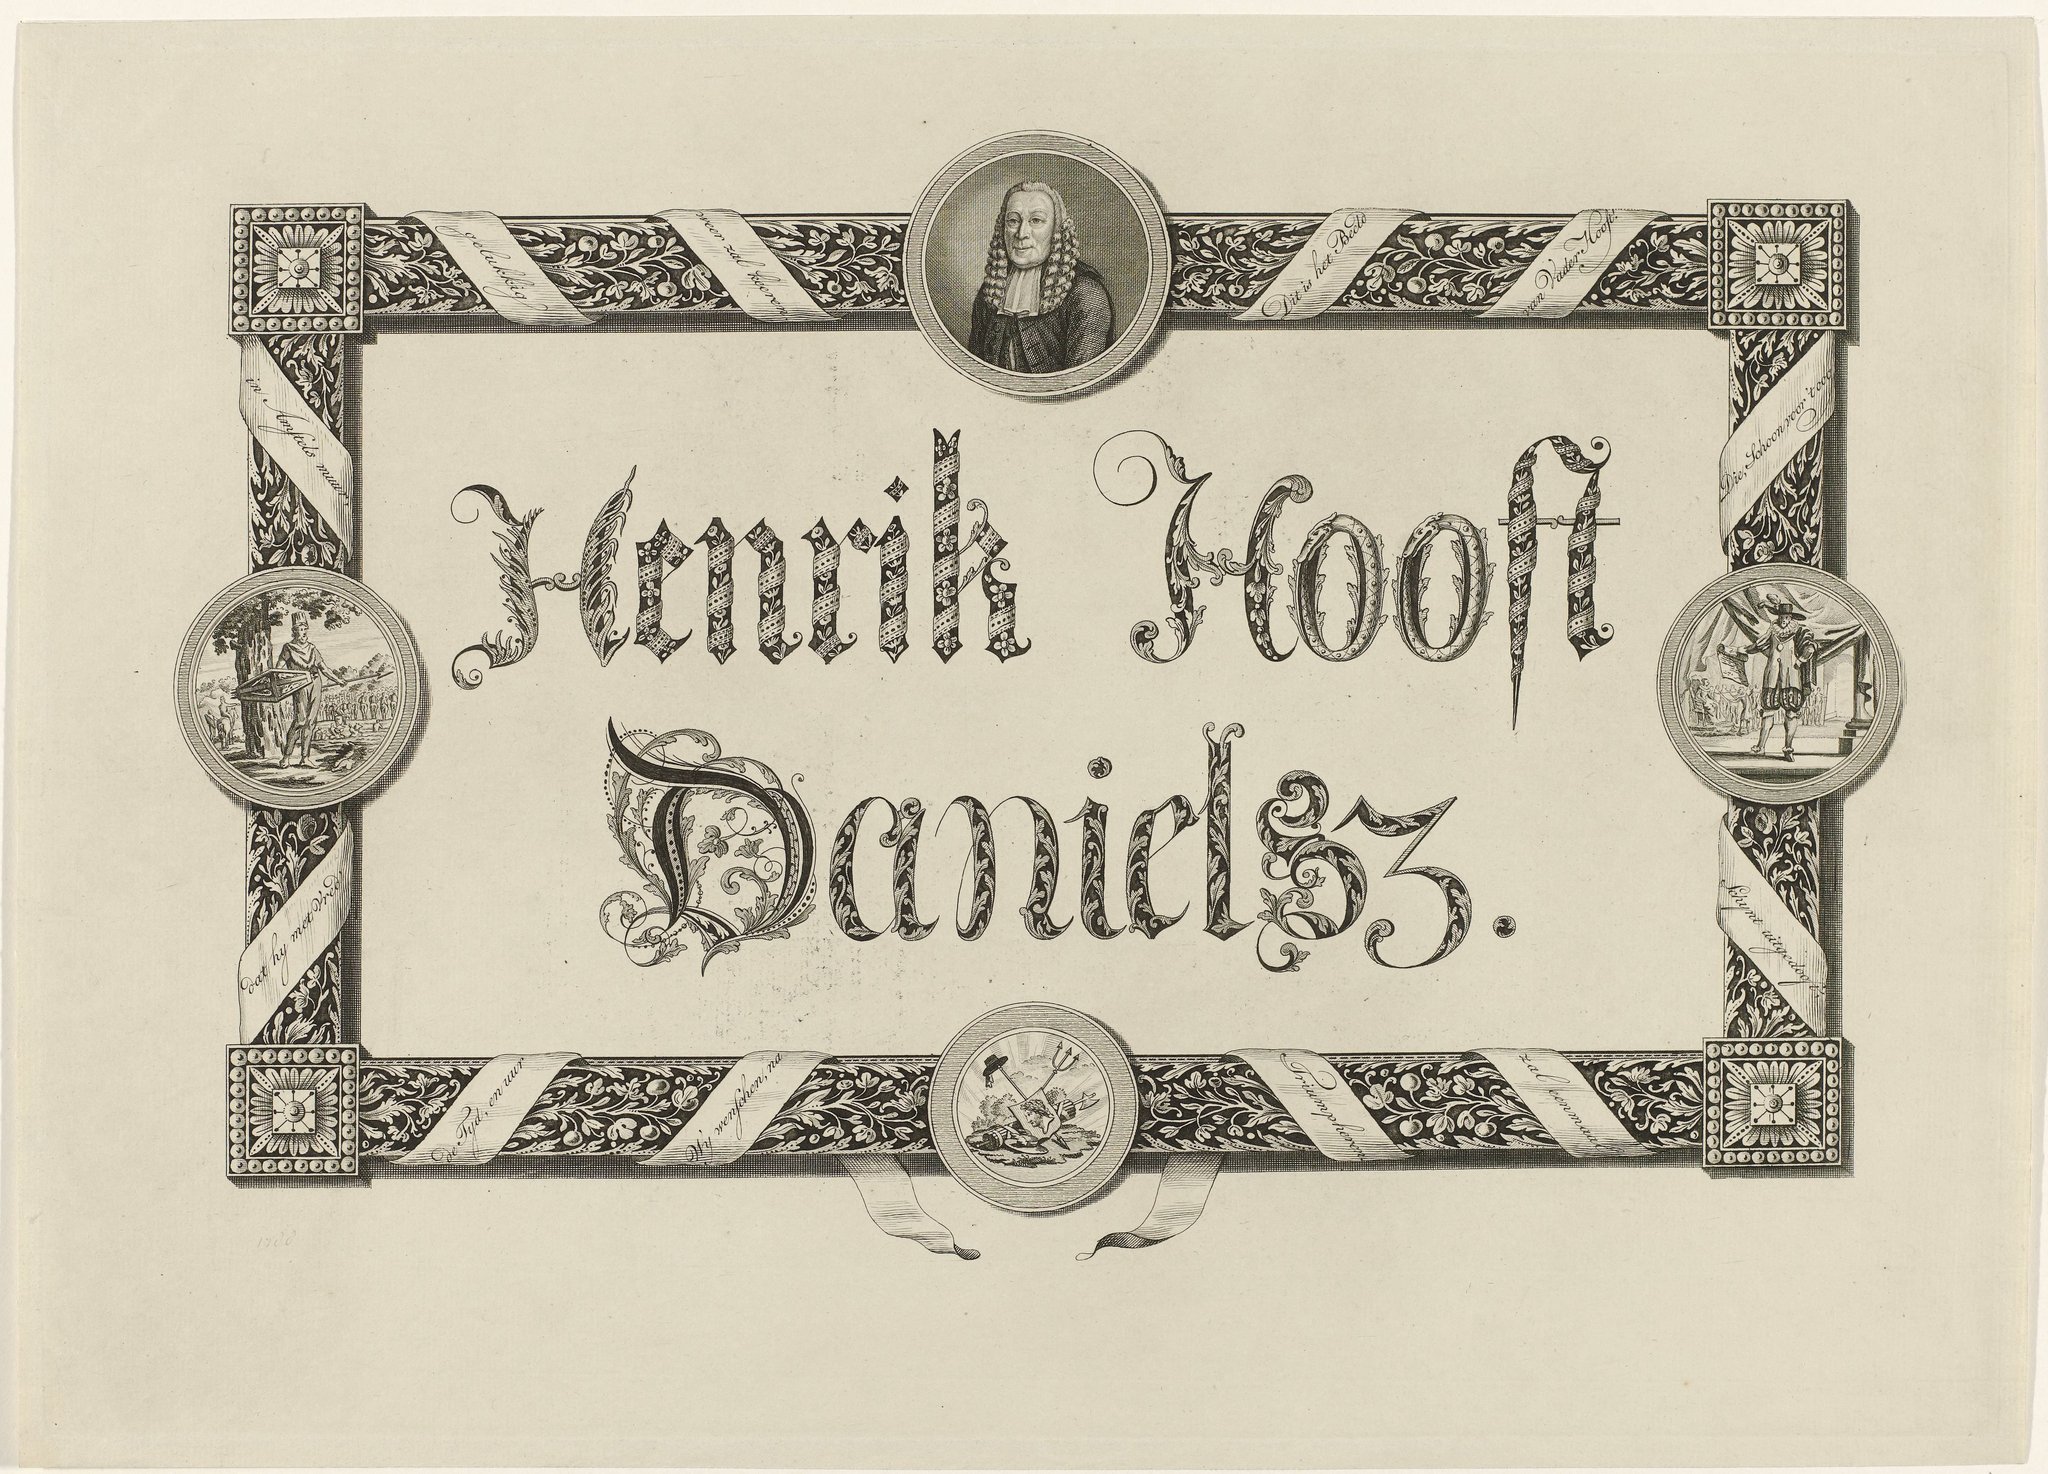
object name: calligraphy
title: Kalligrafie op burgemeester Hendrik Danielsz. Hooft, 1787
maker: leonard jozef ferrier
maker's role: silversmith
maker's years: 1726-1801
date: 1787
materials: paper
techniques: calligraphy, engraving, etching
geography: northern netherlands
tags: amsterdam, mayor, hendrik danielsz. hooft, calligraphy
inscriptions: collector's mark: Lugt 2228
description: Kalligrafie op de Amsterdamse burgemeester Hendrik Danielsz. Hooft, waarschijnlijk naar aanleiding van zijn ontslag op 27 november 1787. Omlijsting met portret en vignetten (o.a. Smeekschrift), om de lijst gewikkeld een banderol met tekst.